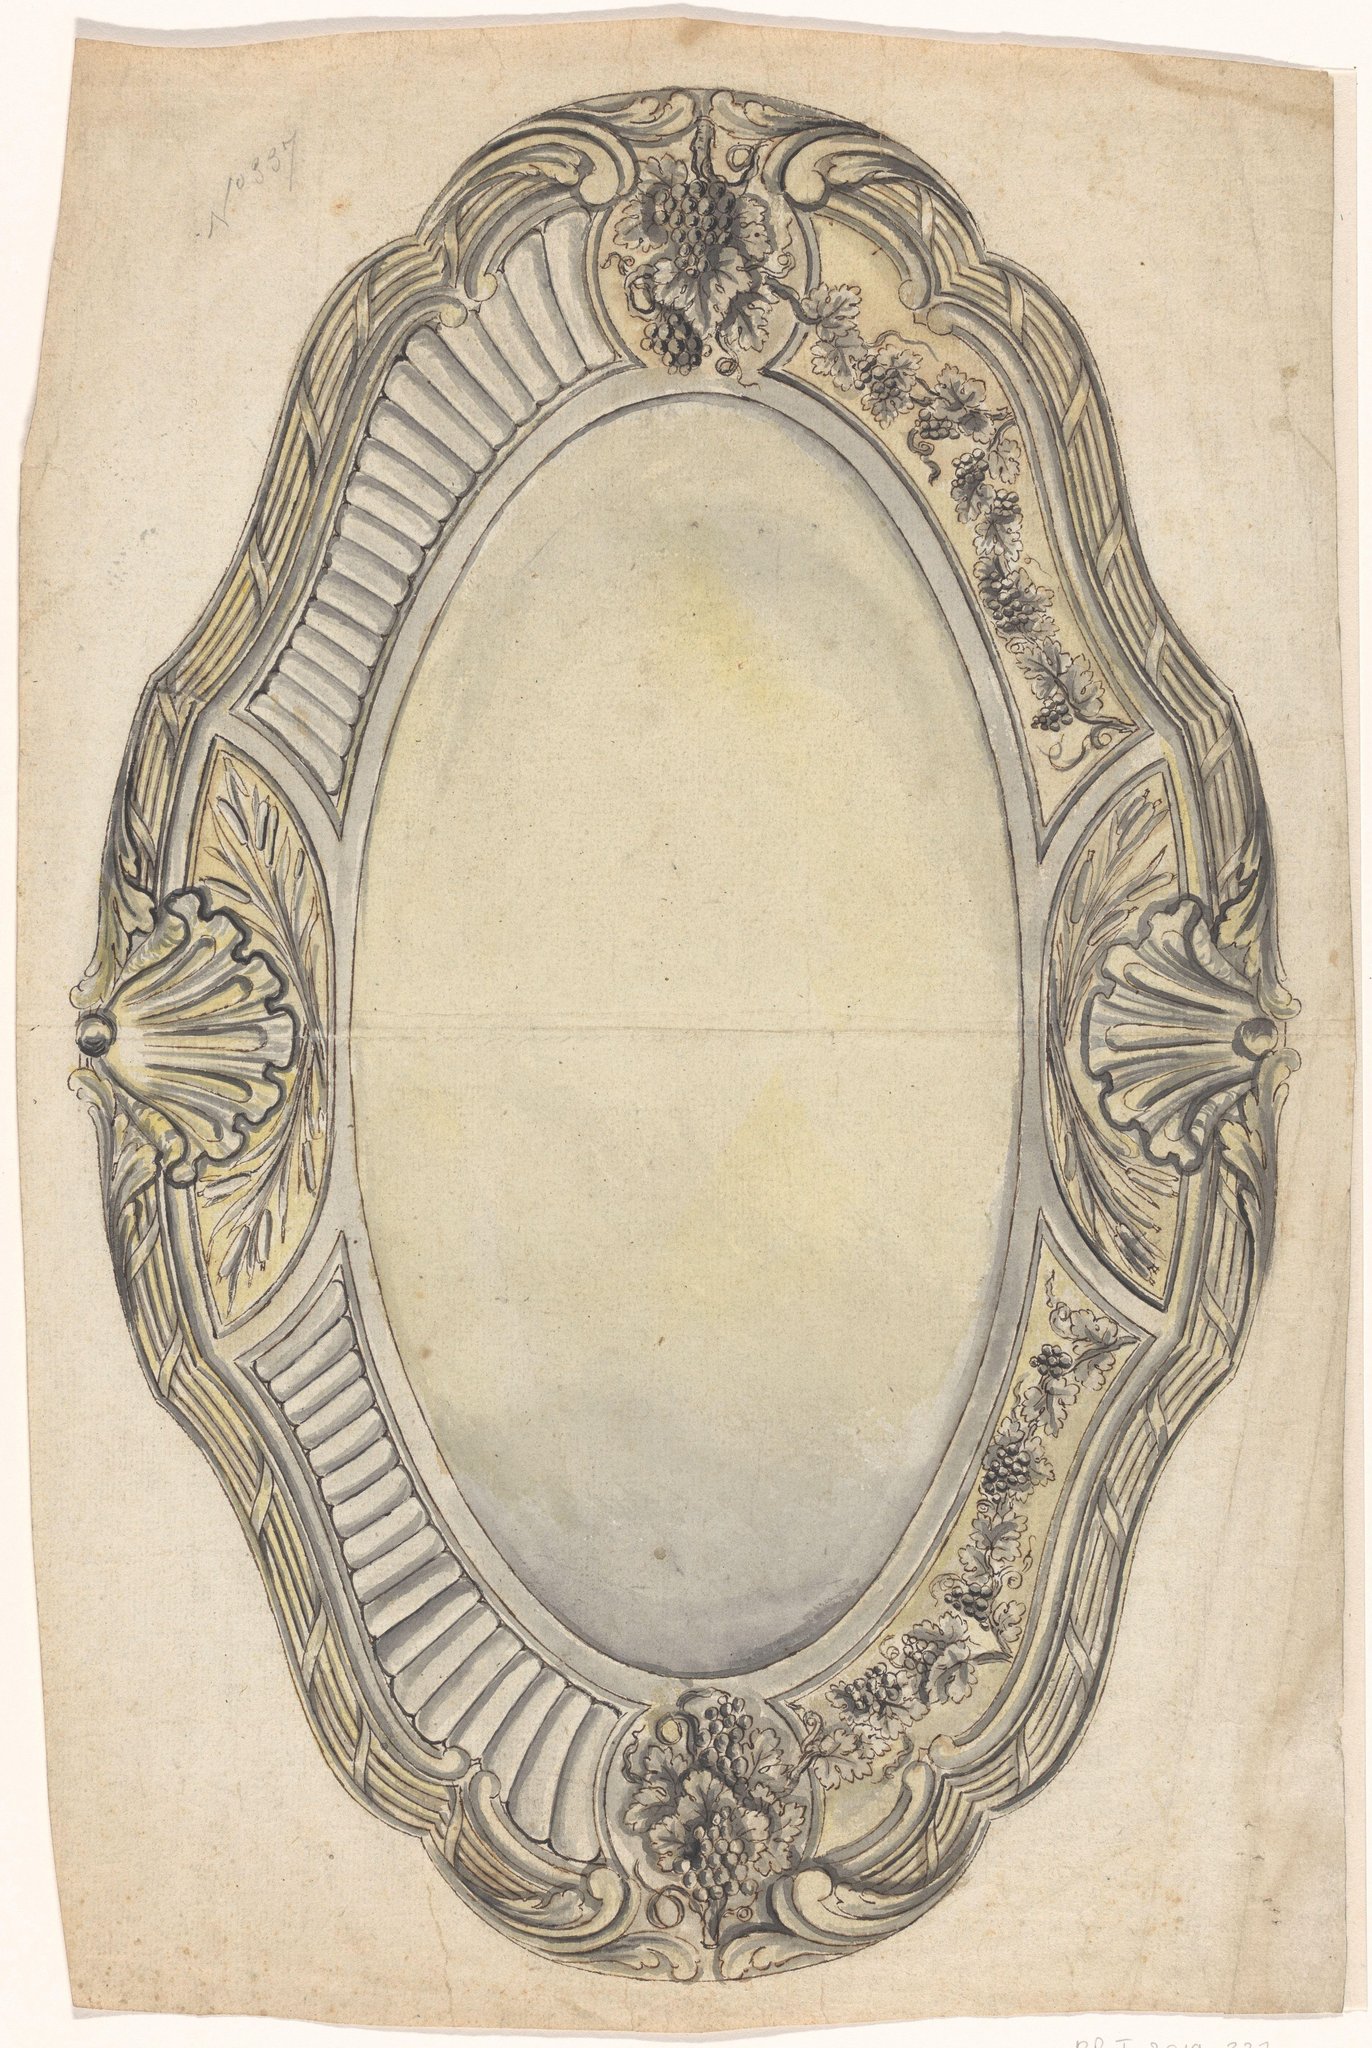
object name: design drawing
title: Ontwerp voor een schaal, met alternatiefoplossing voor de versiering van de rand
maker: Anonymous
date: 1730-1750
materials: paper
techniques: brush, pen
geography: paris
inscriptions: watermark, number: ‘No. 337’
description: In de versiering van de rand zijn druivenranken en rietpluimen weergegeven. Vermoedelijk diende de schaal voor twee kannen, een voor water en een voor wijn, ter gebruik bij de R.K. eredienst.